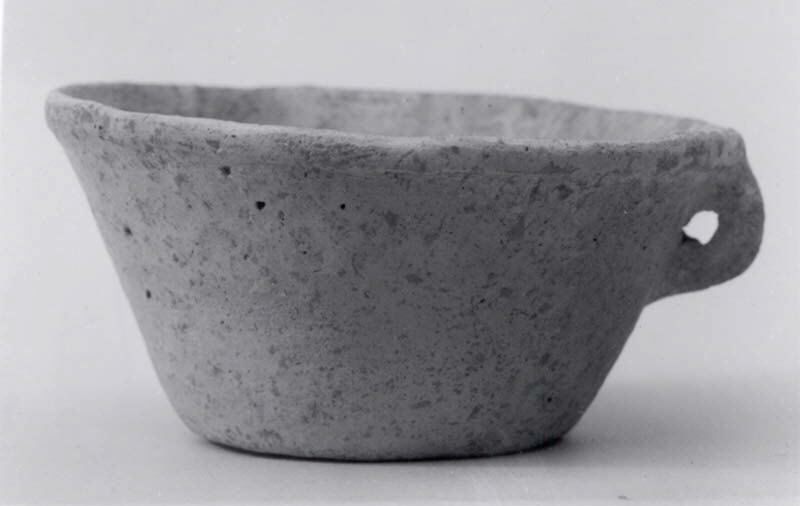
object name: bowl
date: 3000-2001 BCE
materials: ceramic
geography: iran